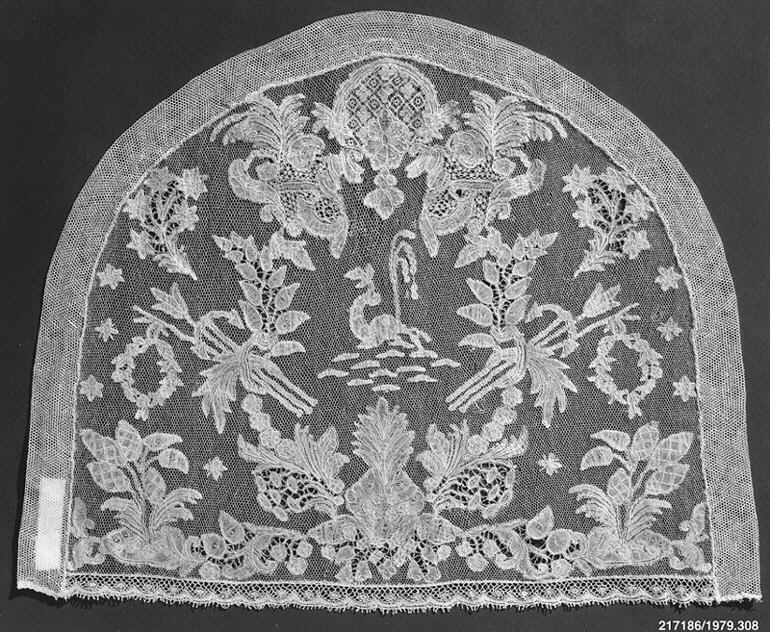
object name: cap crown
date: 1701-1800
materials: linen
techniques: lace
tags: flowers